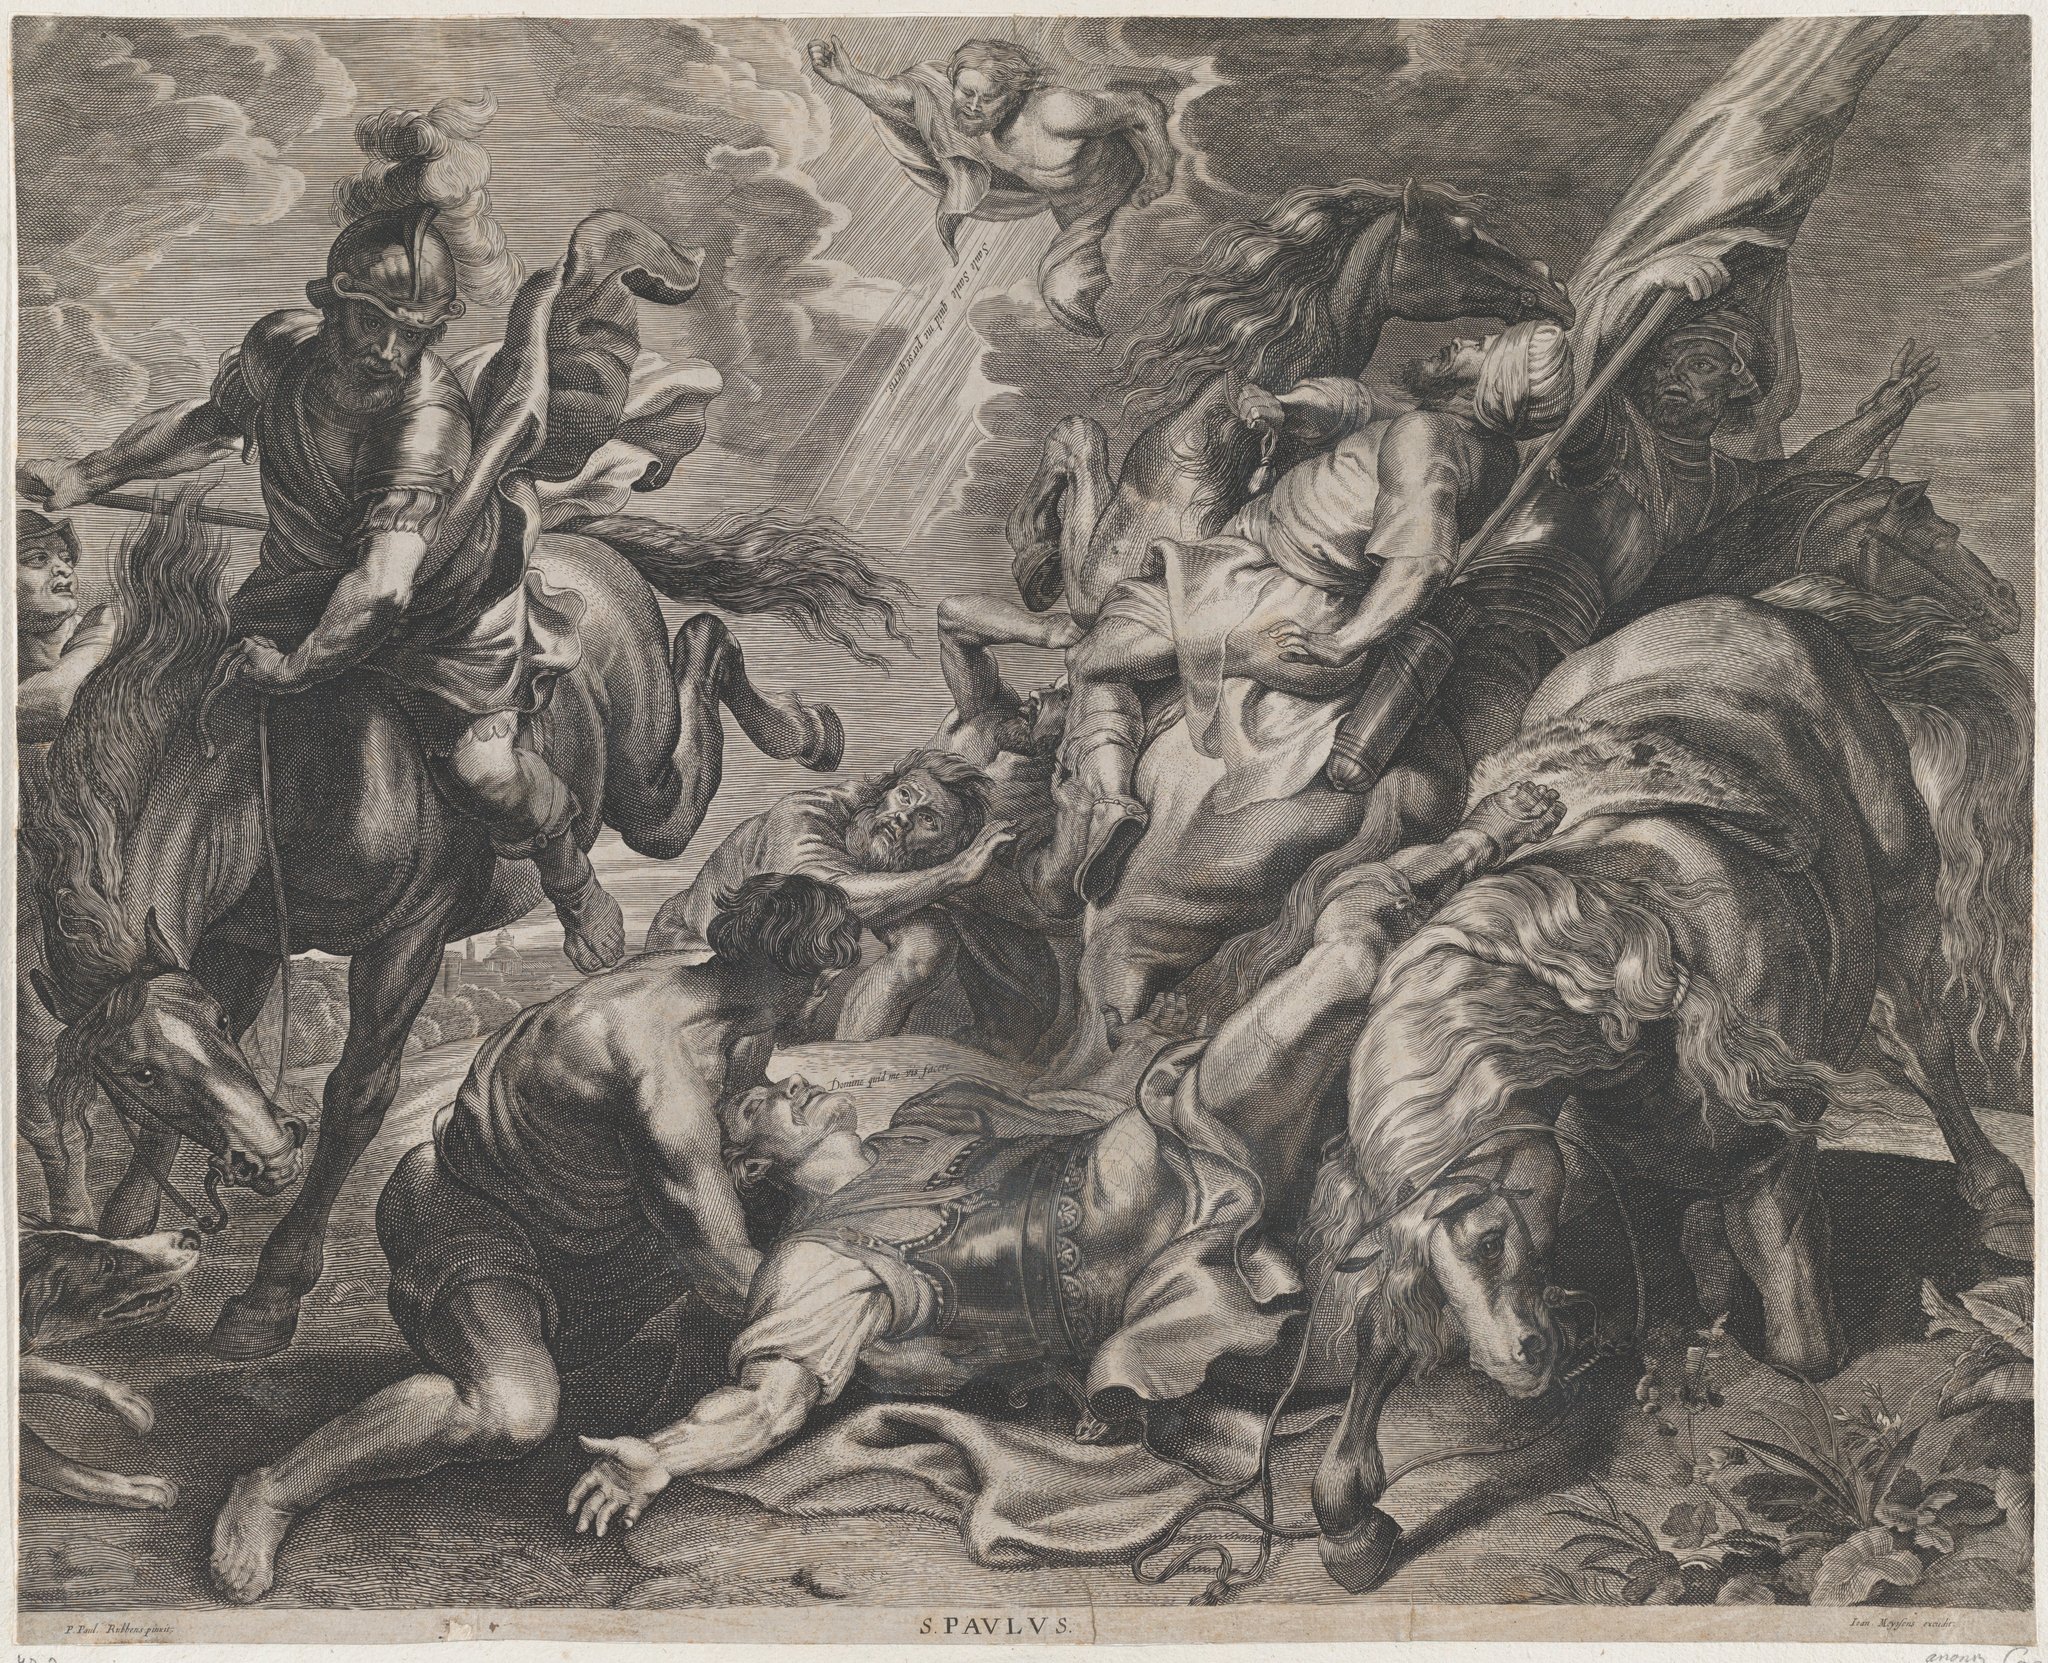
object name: print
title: The Conversion of Saint Paul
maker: johannes meyssens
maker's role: artist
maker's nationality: flemish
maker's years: 1612-1670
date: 1601-1700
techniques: engraving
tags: men,horses,angels,saint paul